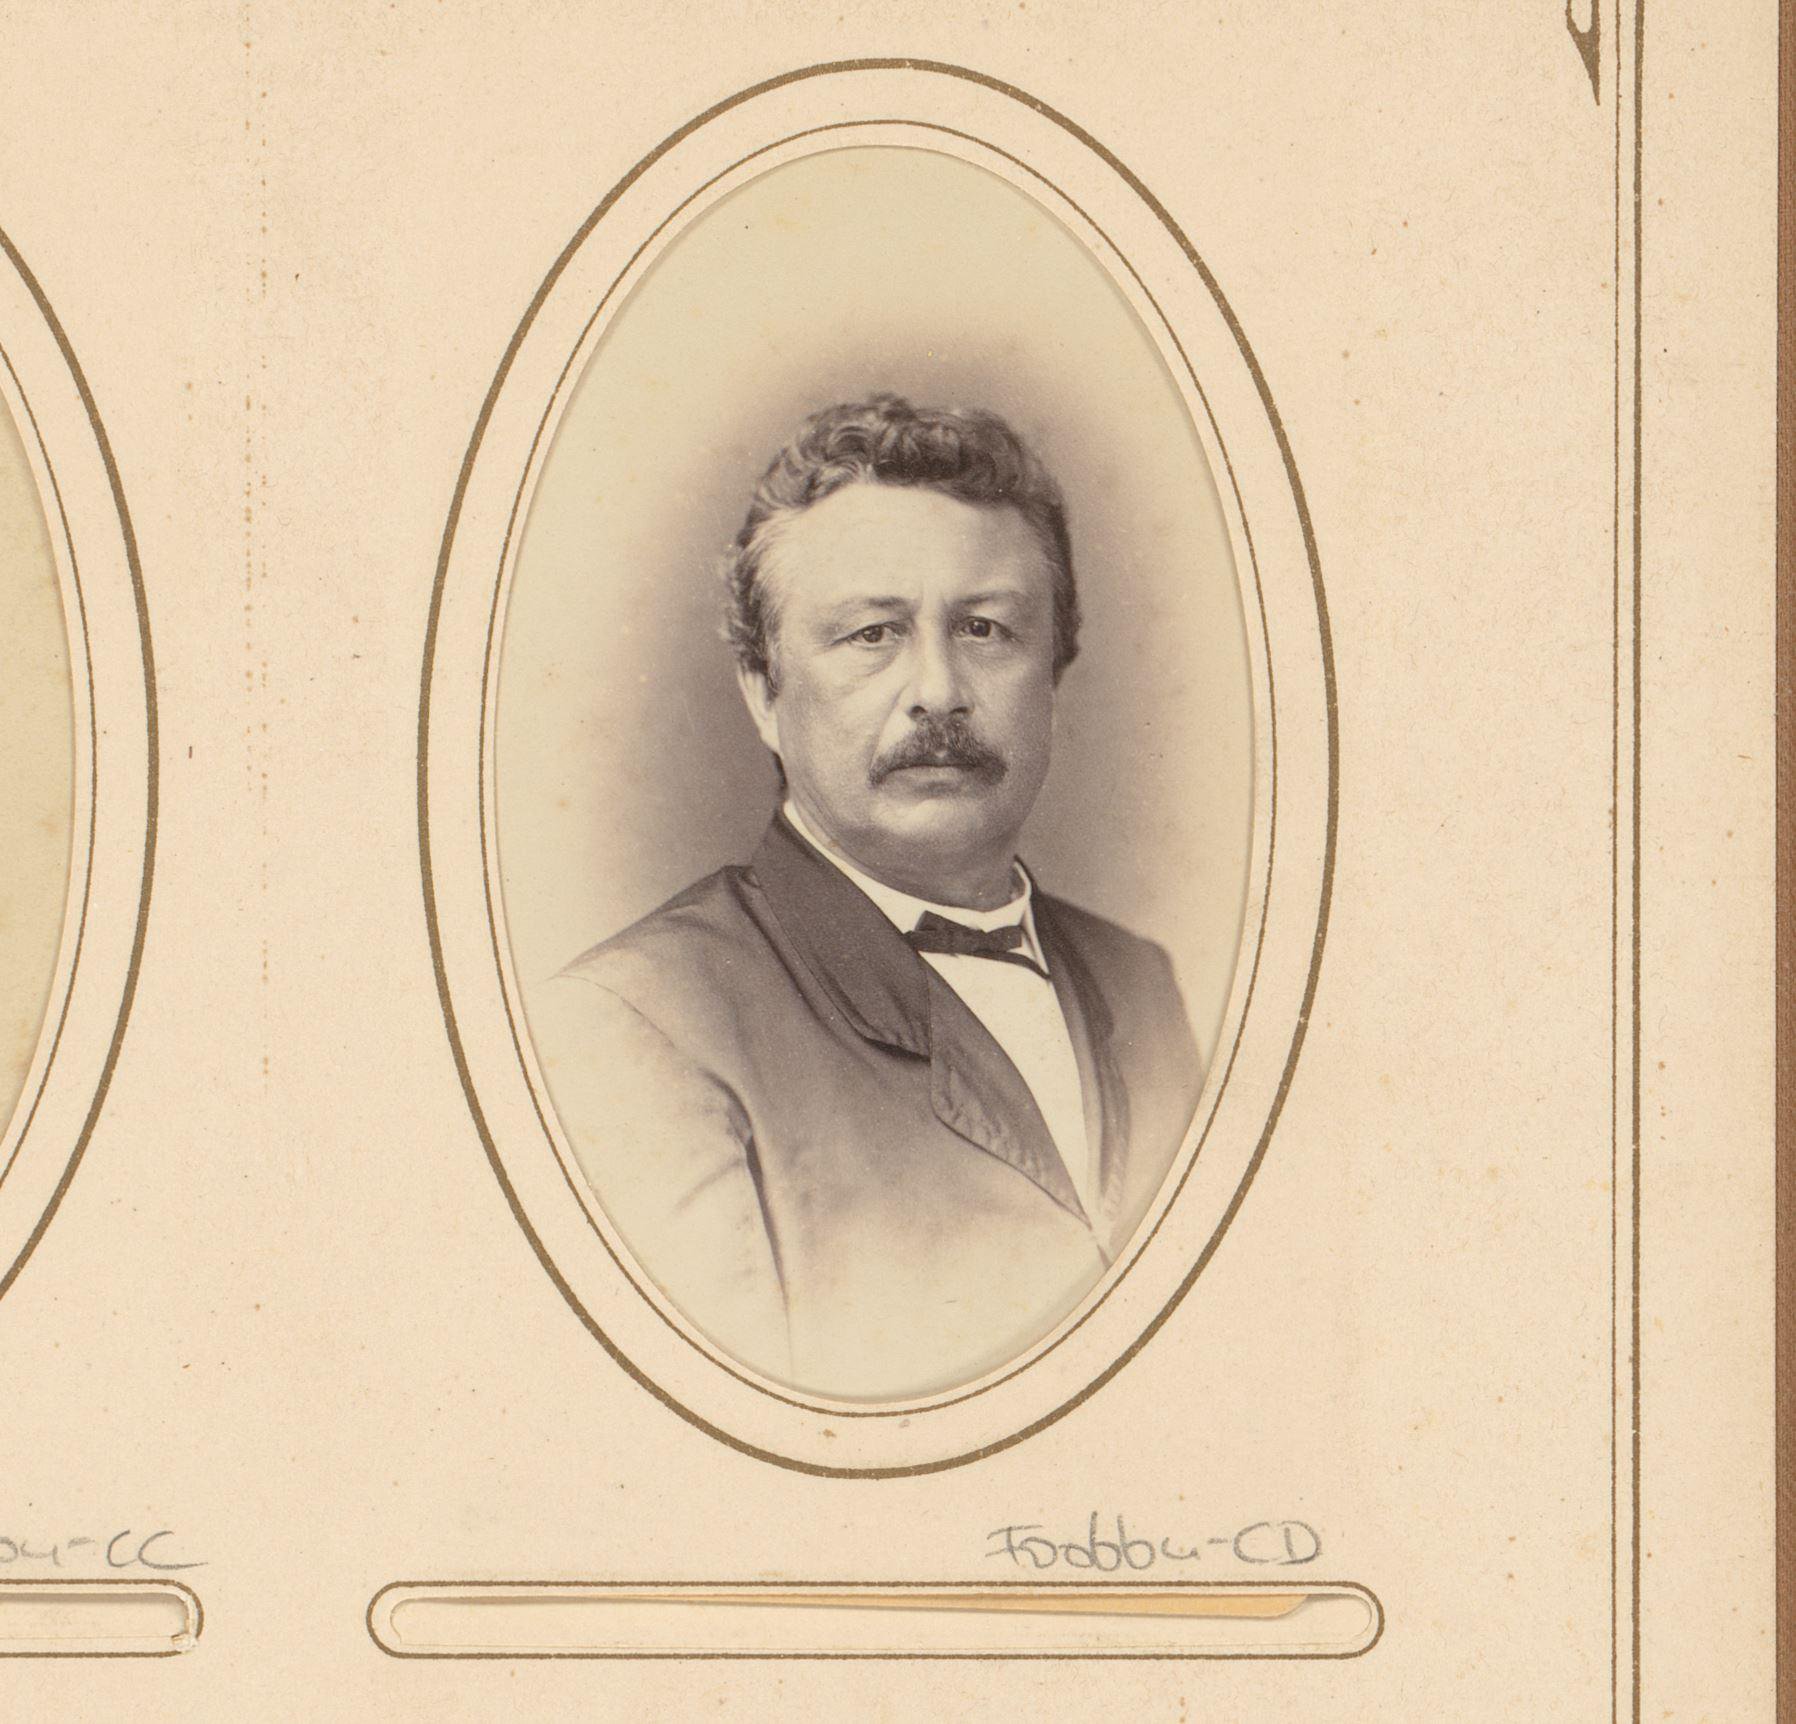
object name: carte de visite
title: Portret van een man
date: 1860-1880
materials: cardboard, photographic support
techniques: albumen print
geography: java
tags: historical persons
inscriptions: inscription: ‘Woodbury & Page/ Photographers/ Java’